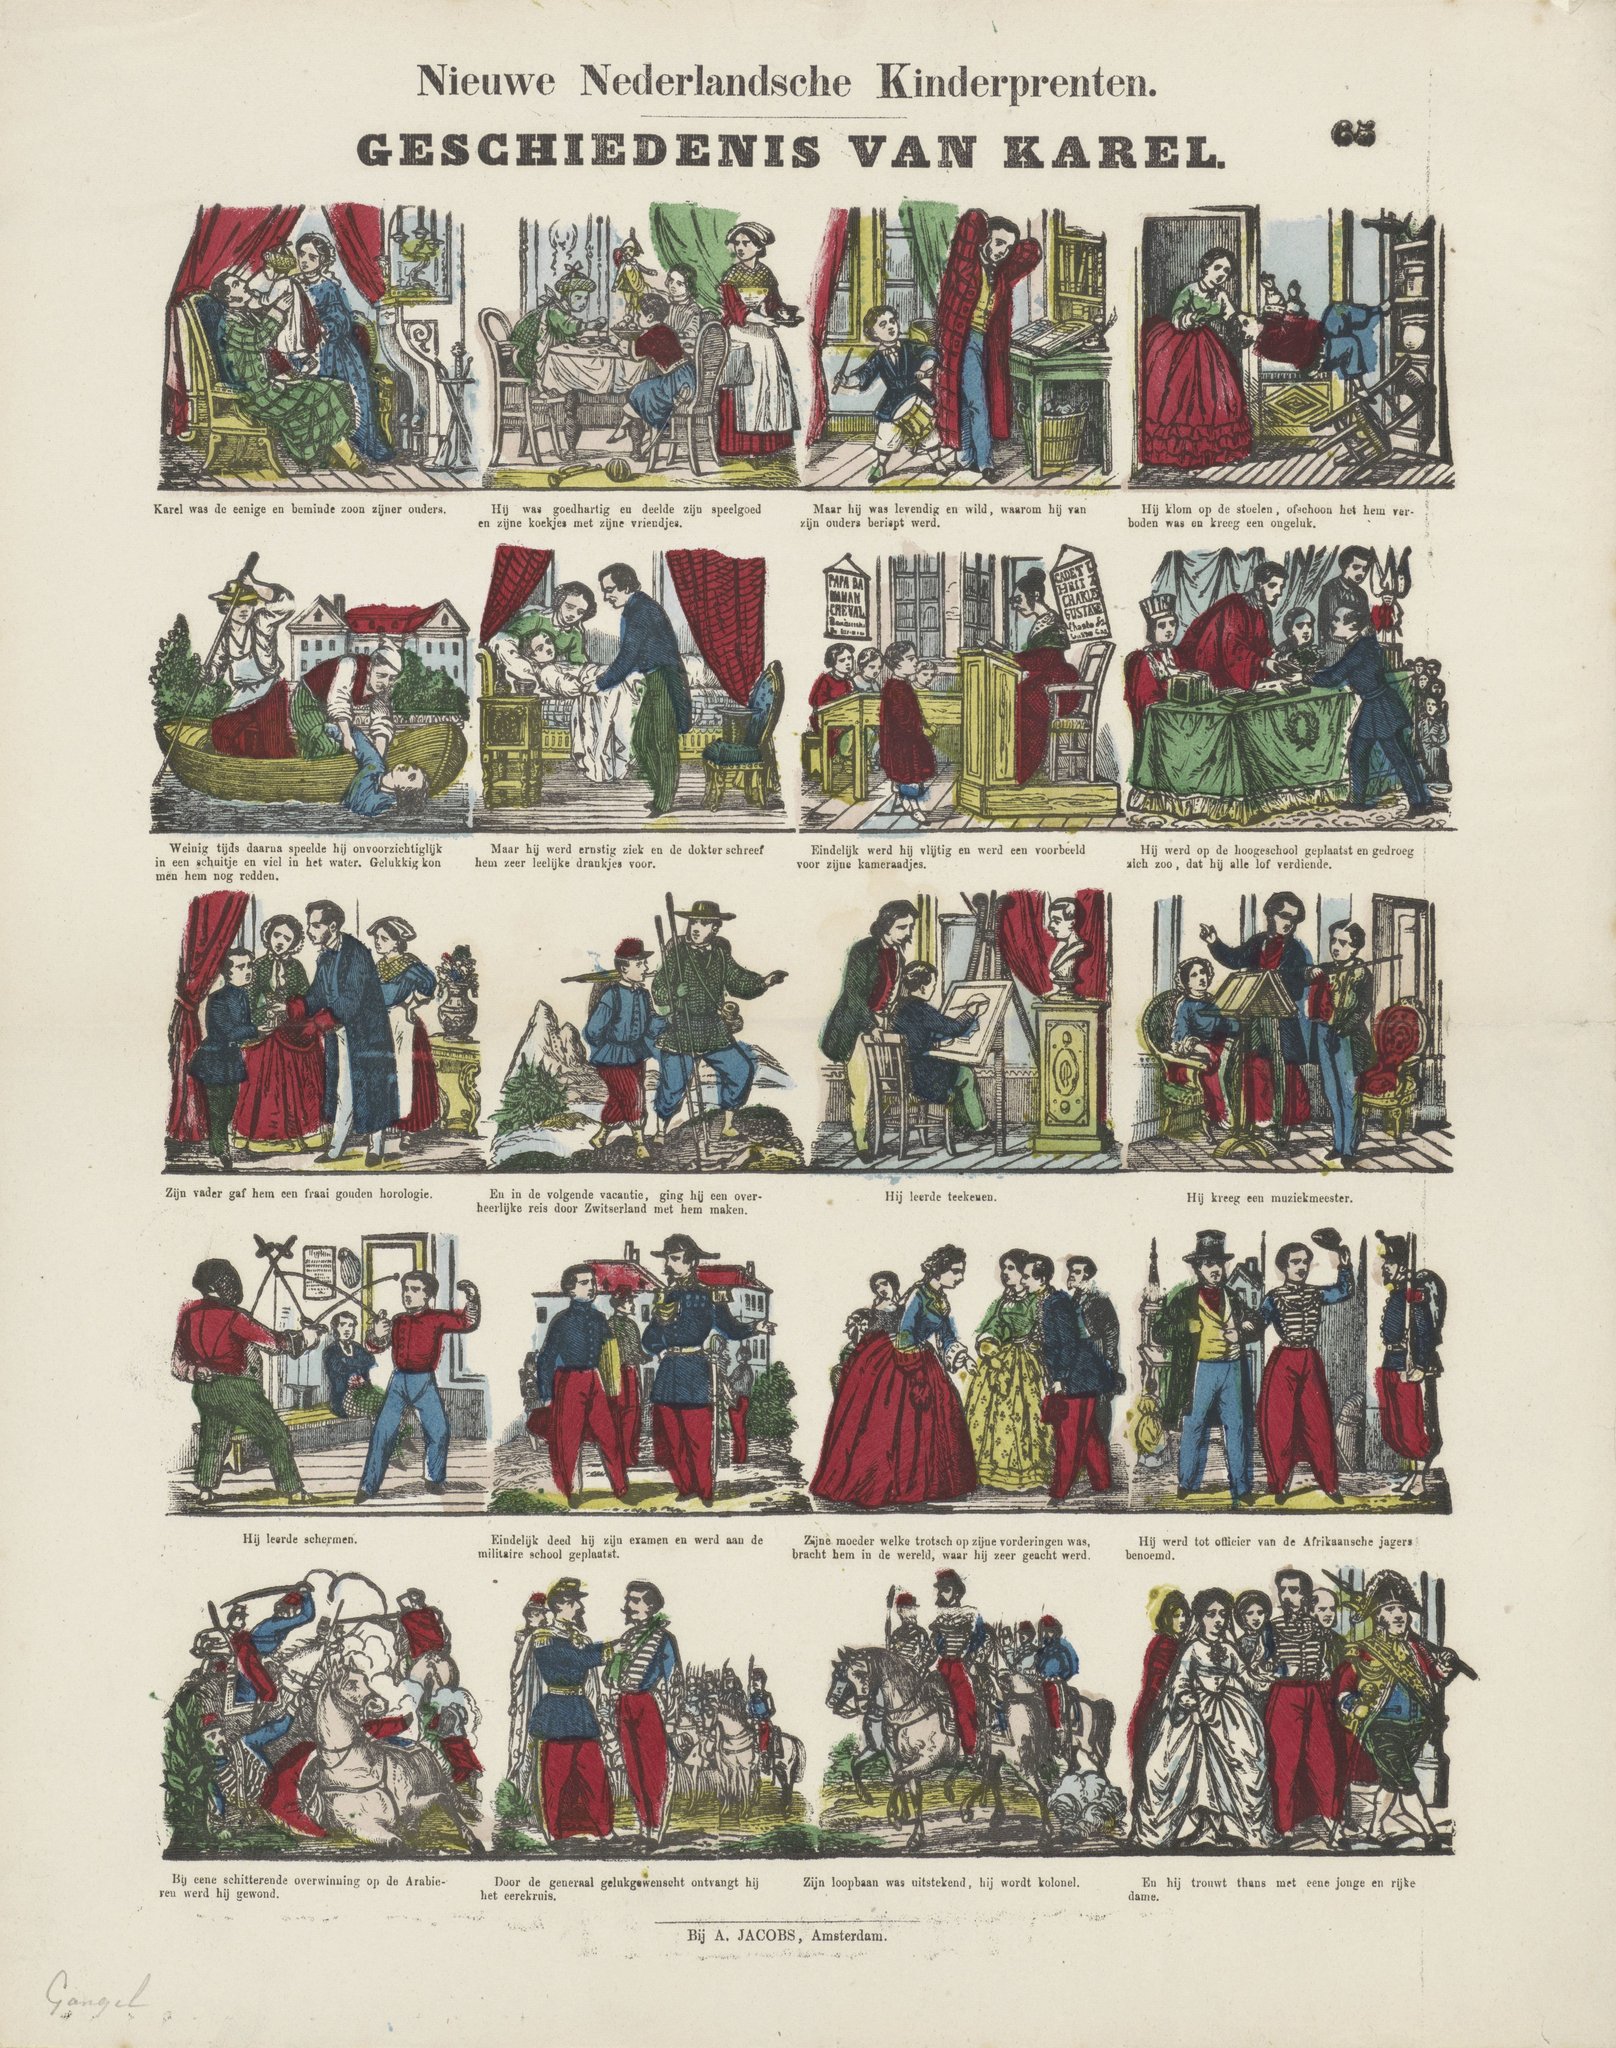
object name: print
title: Nieuwe Nederlandsche kinderprenten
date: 1840-1868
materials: paper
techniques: hand coloring, letterpress printing, lithograph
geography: metz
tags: tales and fairy tales, human life divided into stages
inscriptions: collector's mark: Lugt 2760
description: Blad met 20 voorstellingen over het leven van Karel, van zijn jeugd tot zijn huwelijk. Onder elke afbeelding een onderschrift. Genummerd rechtsboven: 65.